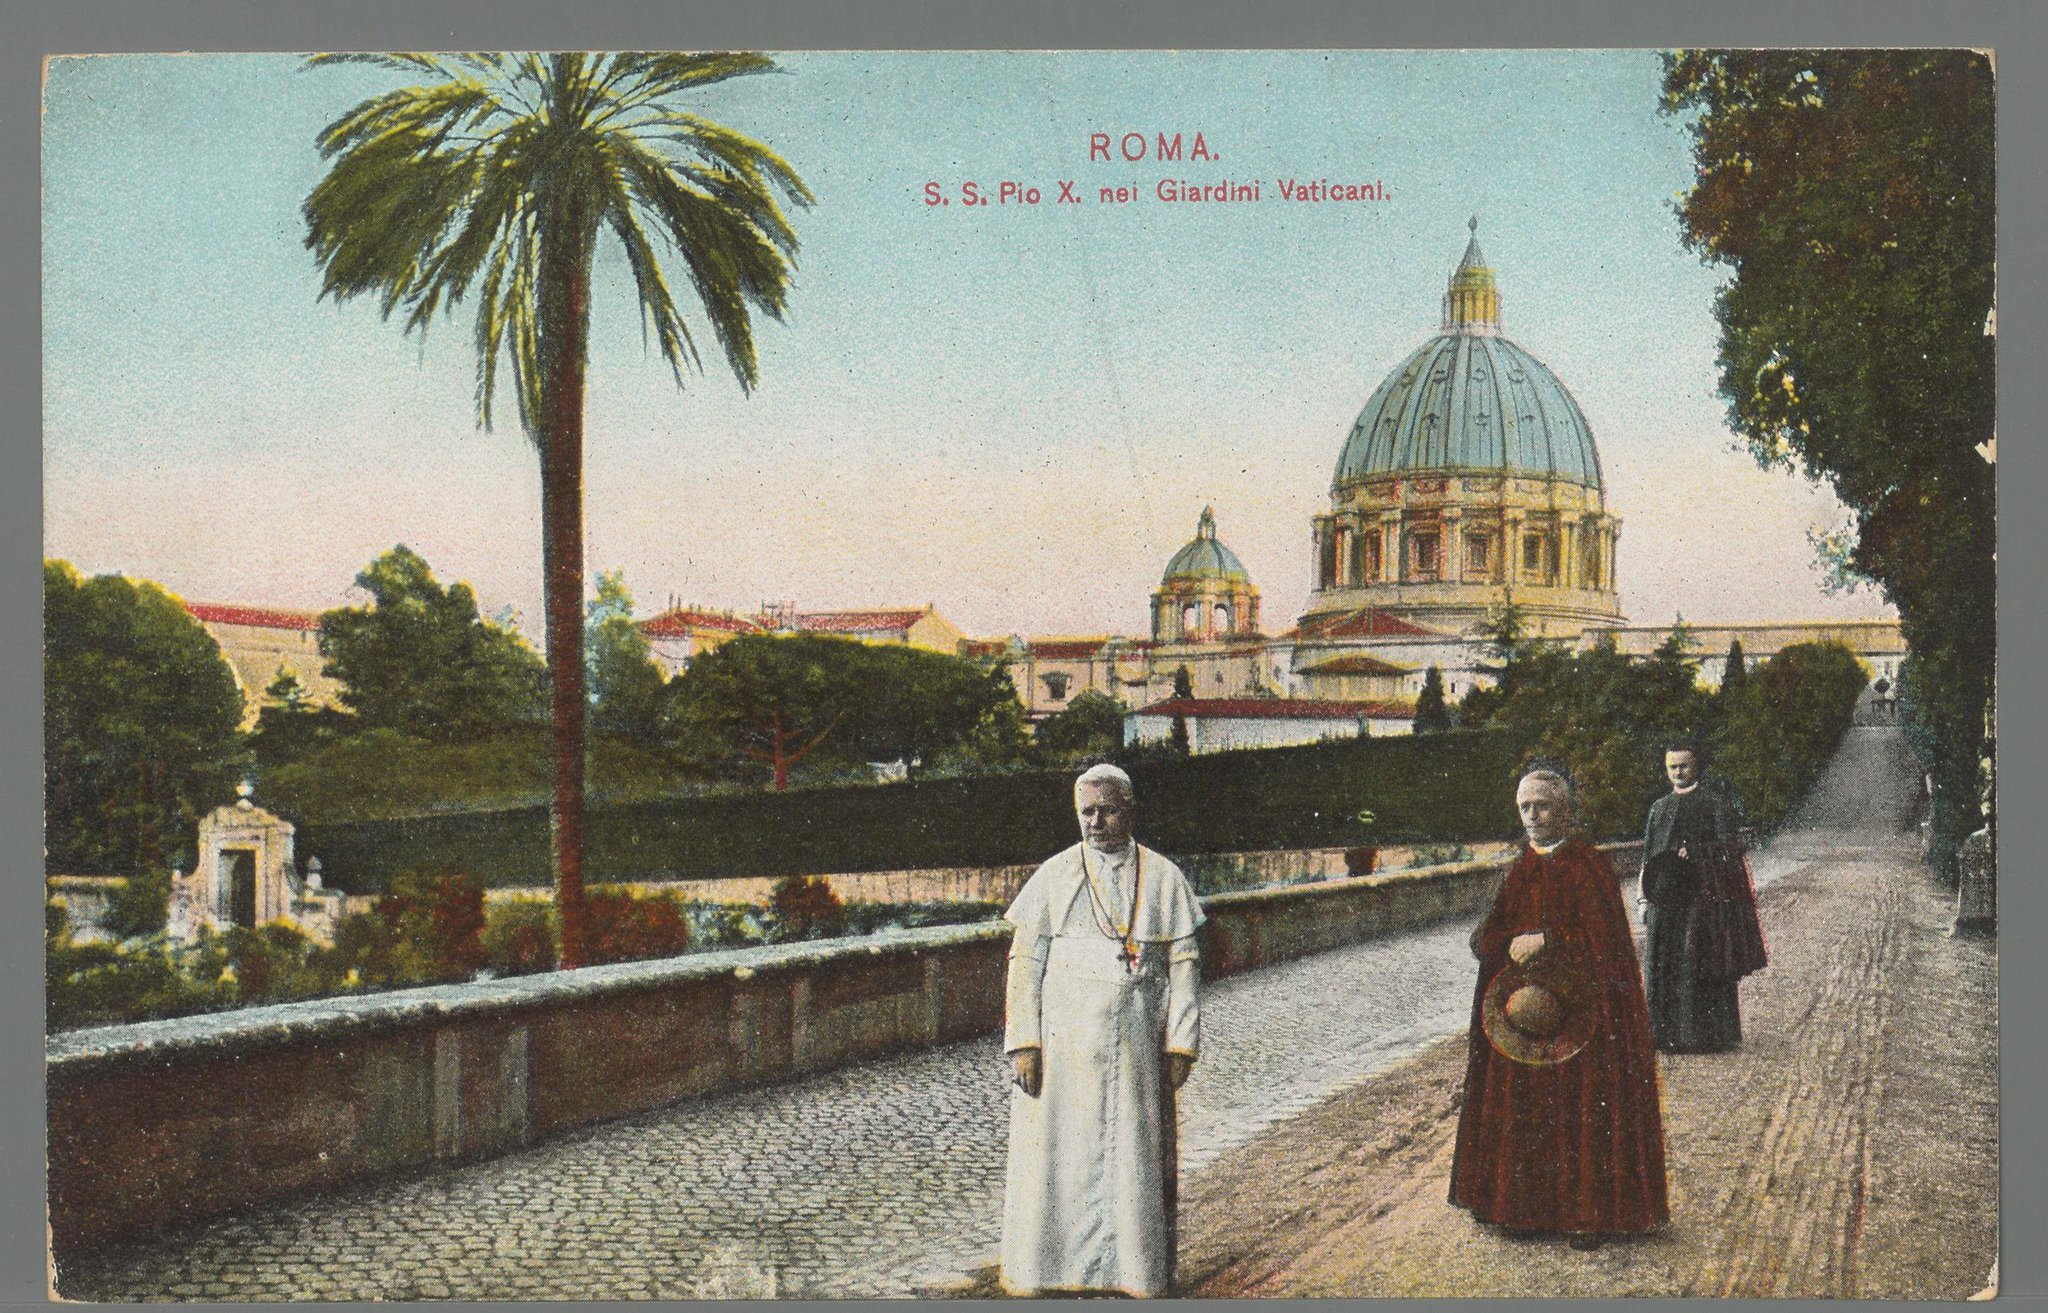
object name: ansichtkaart, prentbriefkaart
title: Roma. S. S. Pio X. nei Giardini Vaticani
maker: Anonymous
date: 1906-1920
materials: cardboard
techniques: lithograph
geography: rome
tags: rome, garden, church (exterior), pope